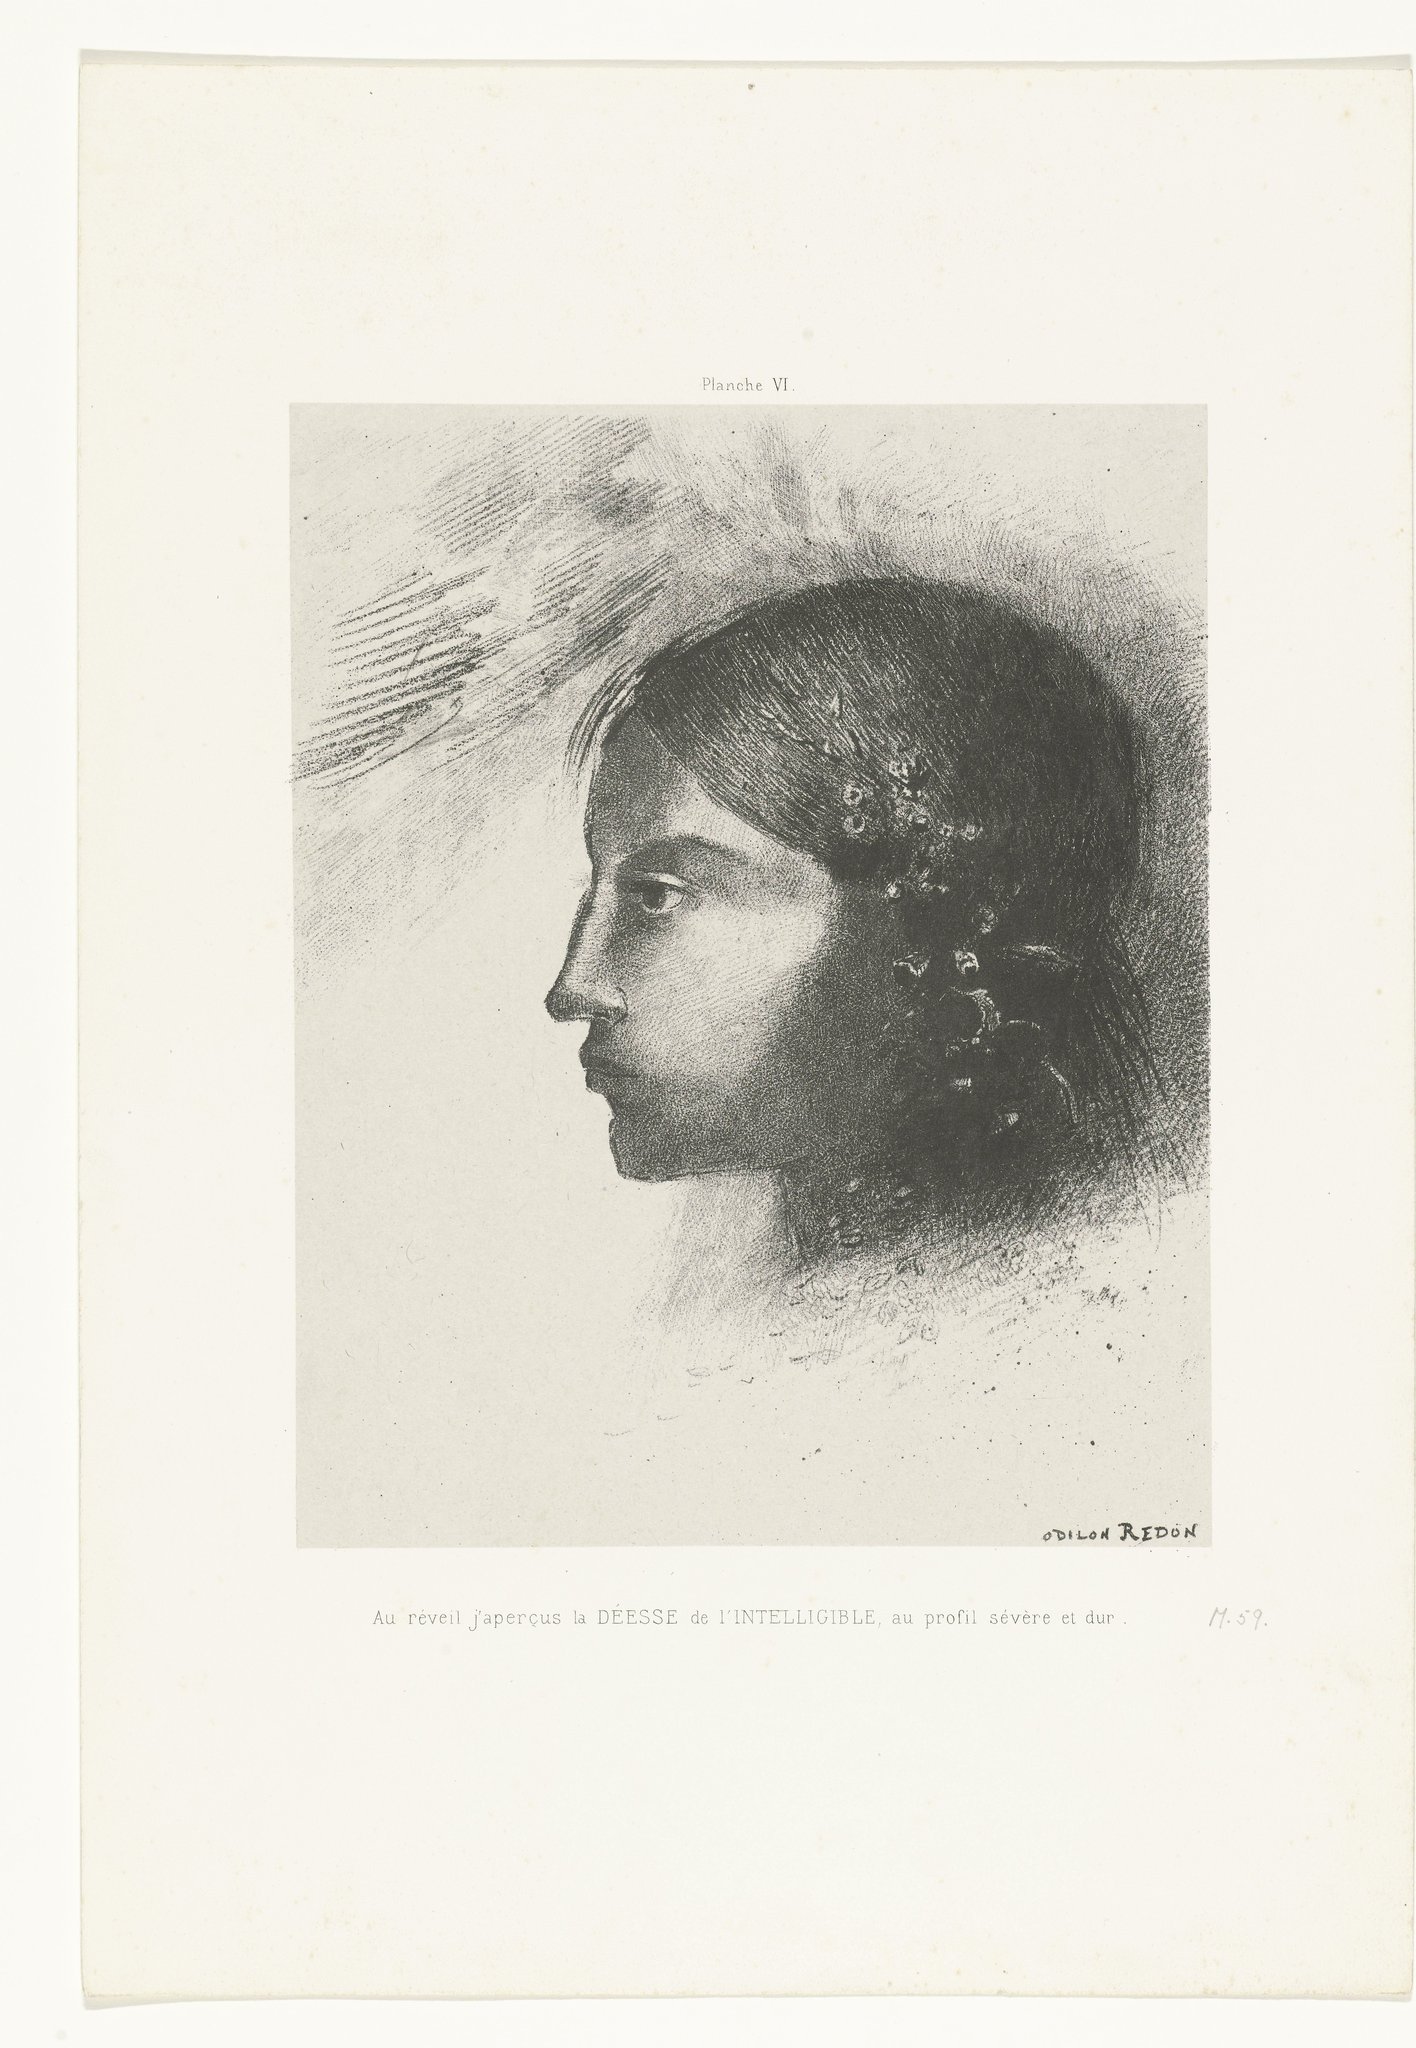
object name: print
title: Ontwakend zag ik de Godin van de verstaanbaarheid met haar strenge en harde profiel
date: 1885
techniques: printmaking, lithograph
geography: paris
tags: representations ~ goddesses, demi-goddesses, heroines, etc. (non-christian religions)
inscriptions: collector's mark: Lugt 2228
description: Hoofd van een vrouw met bloemen in het haar. Zesde prent van zes uit het album "Hommage a Goya".